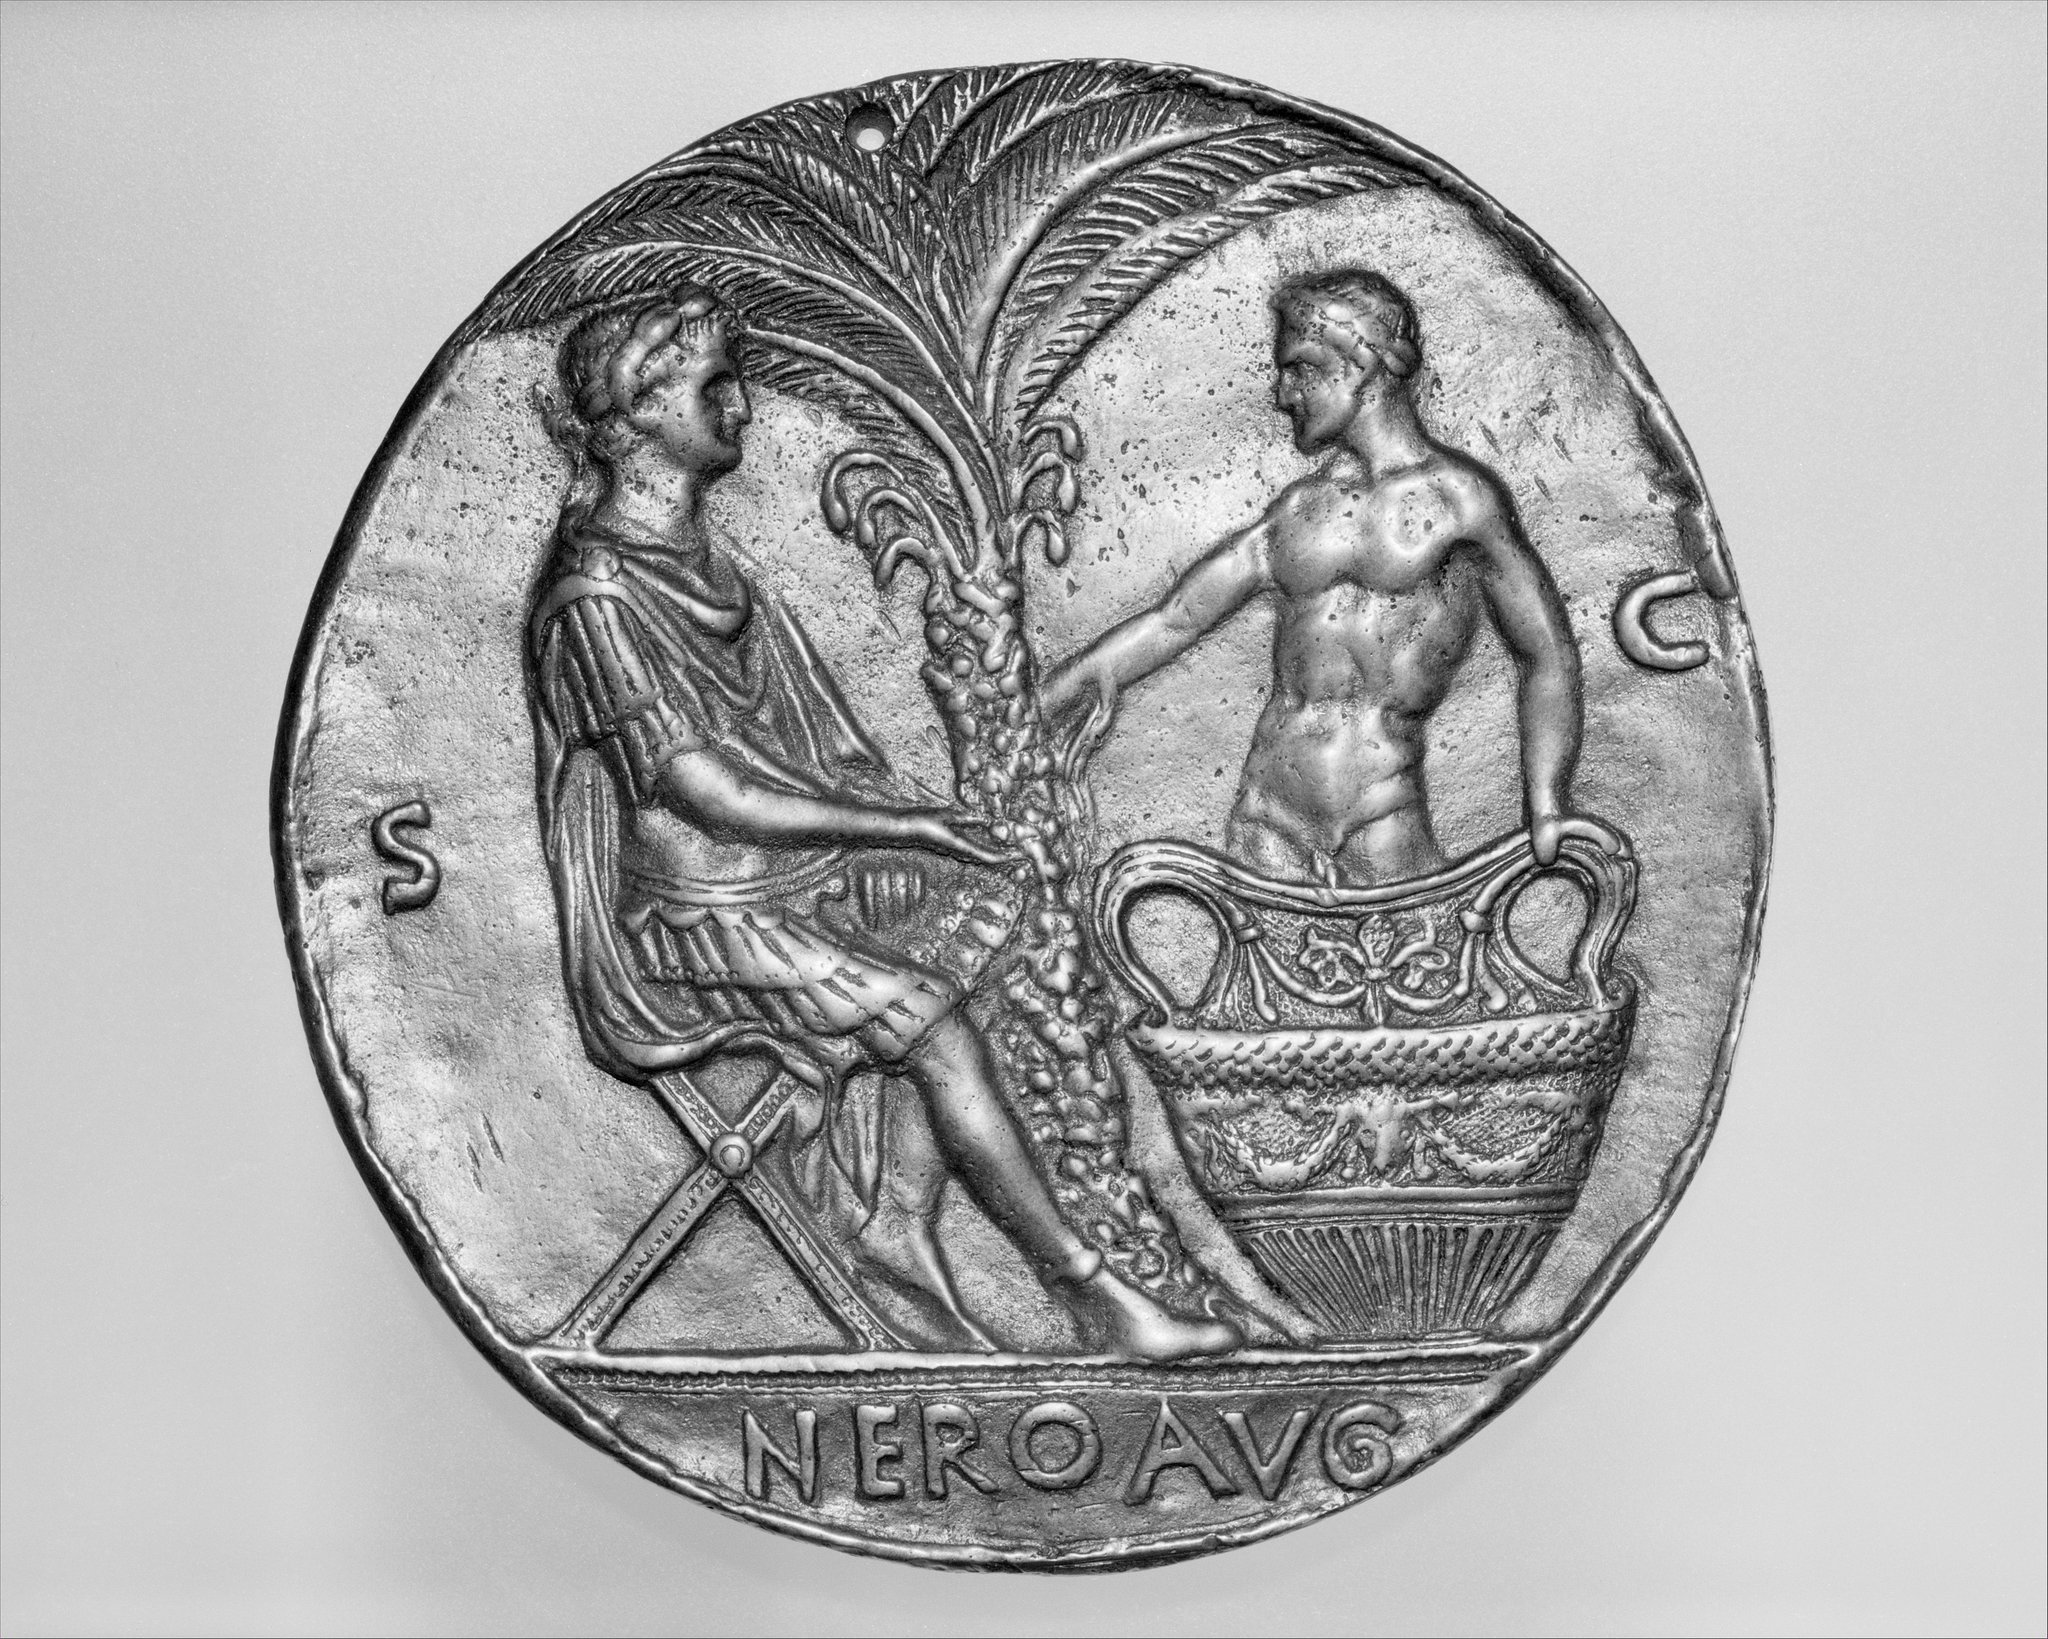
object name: medal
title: Nero and the Dying Seneca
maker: master of the roman emperors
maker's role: artist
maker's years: 1400-1500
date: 1445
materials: bronze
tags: nero,men,trees